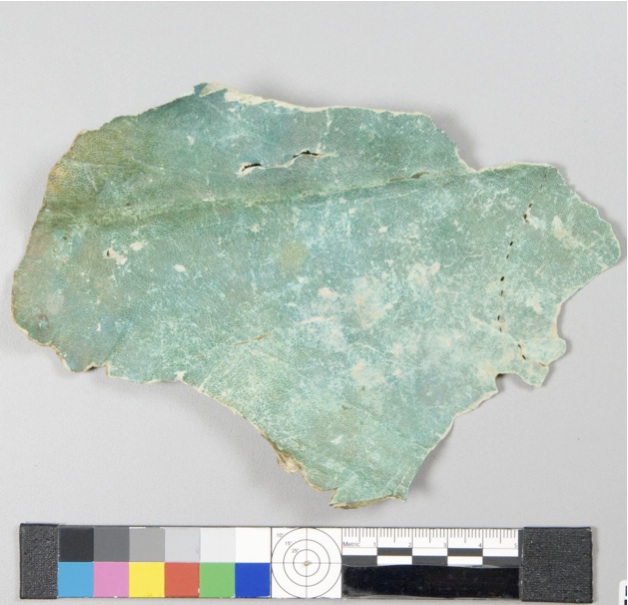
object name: leather fragment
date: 2124-1504 BCE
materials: leather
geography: egypt